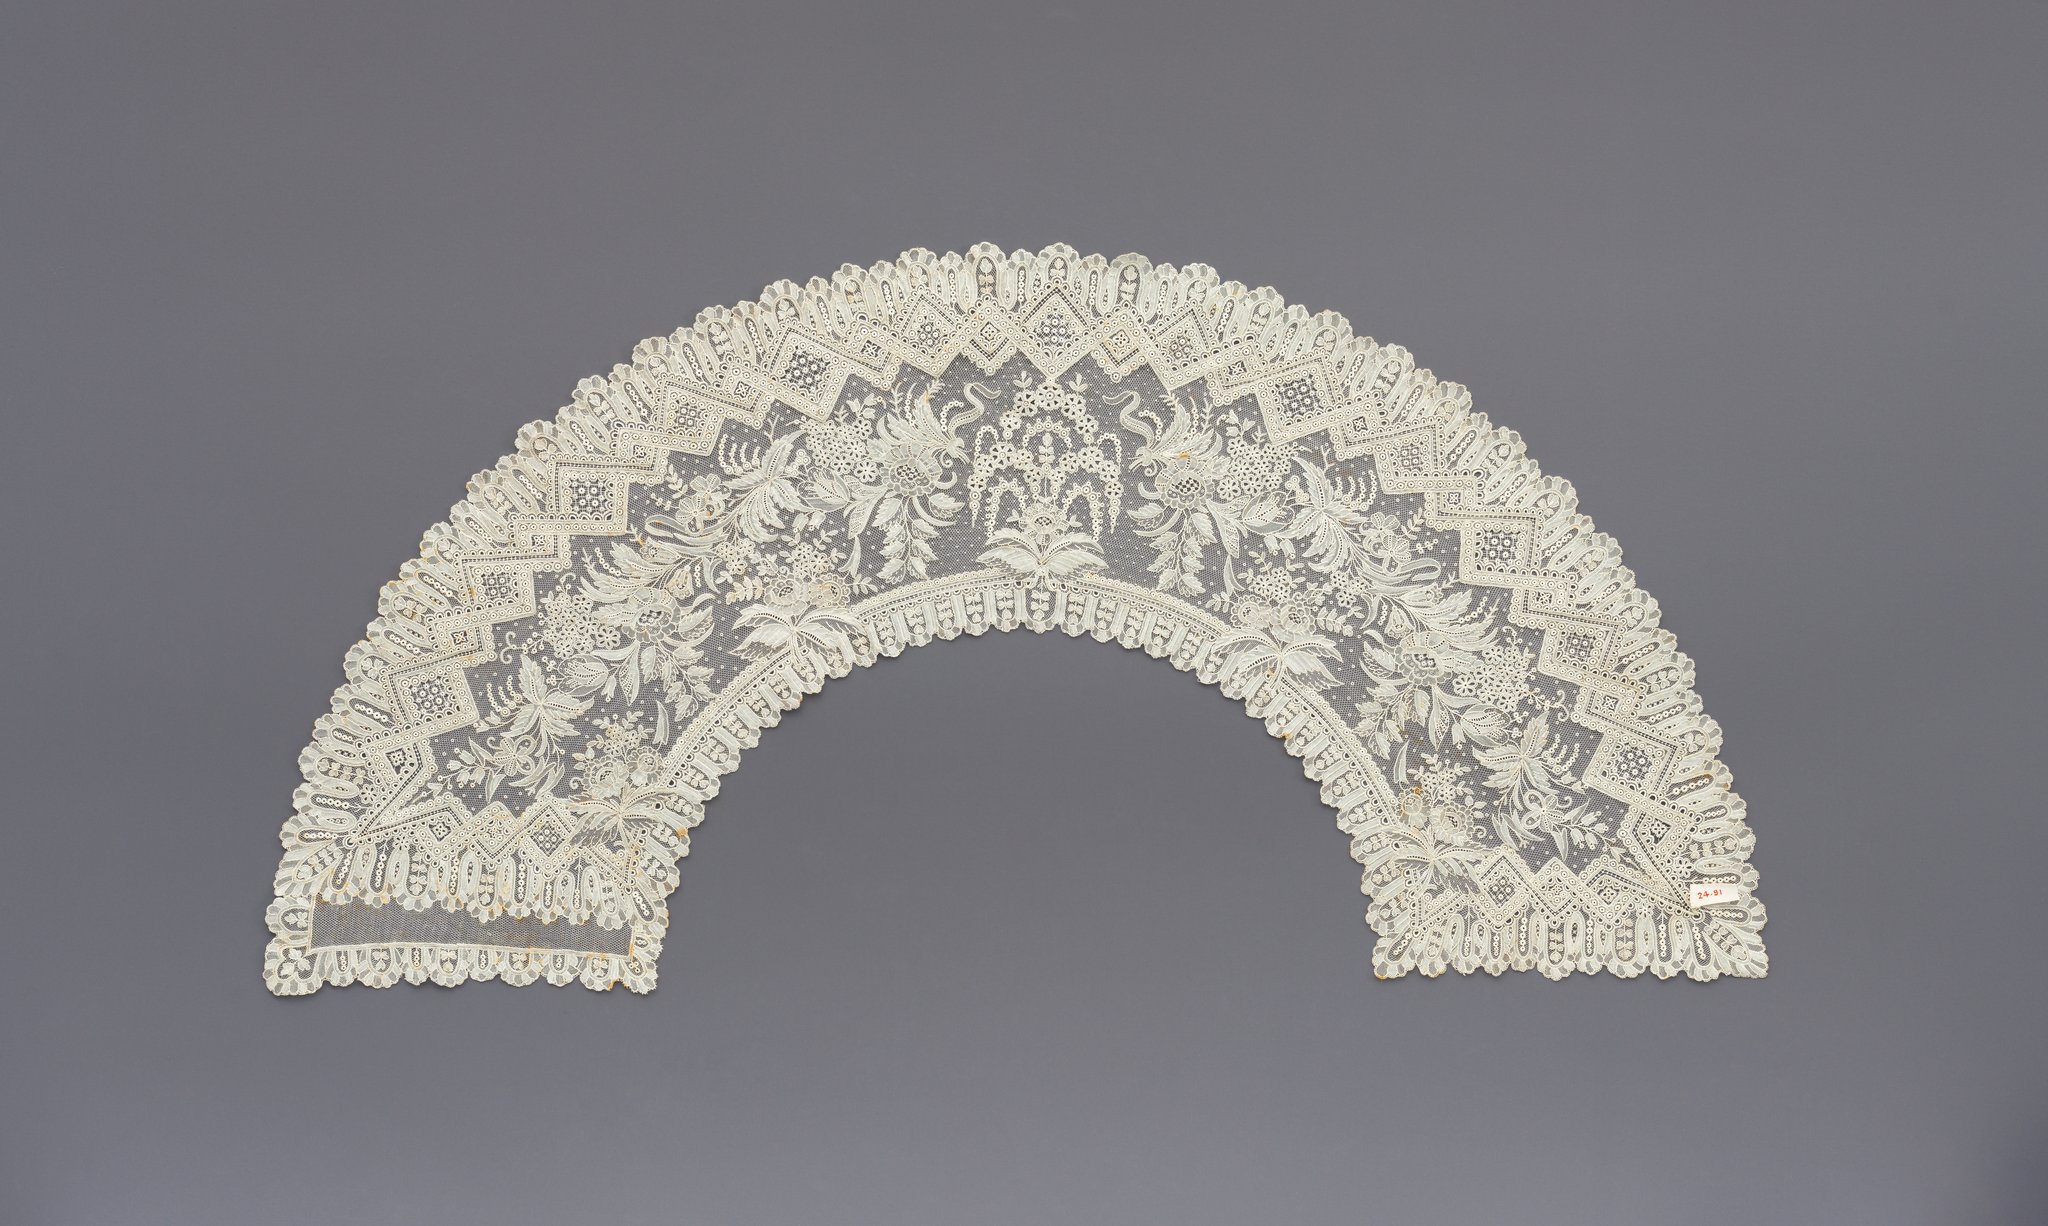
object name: fan leaf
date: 1801-1900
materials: lace